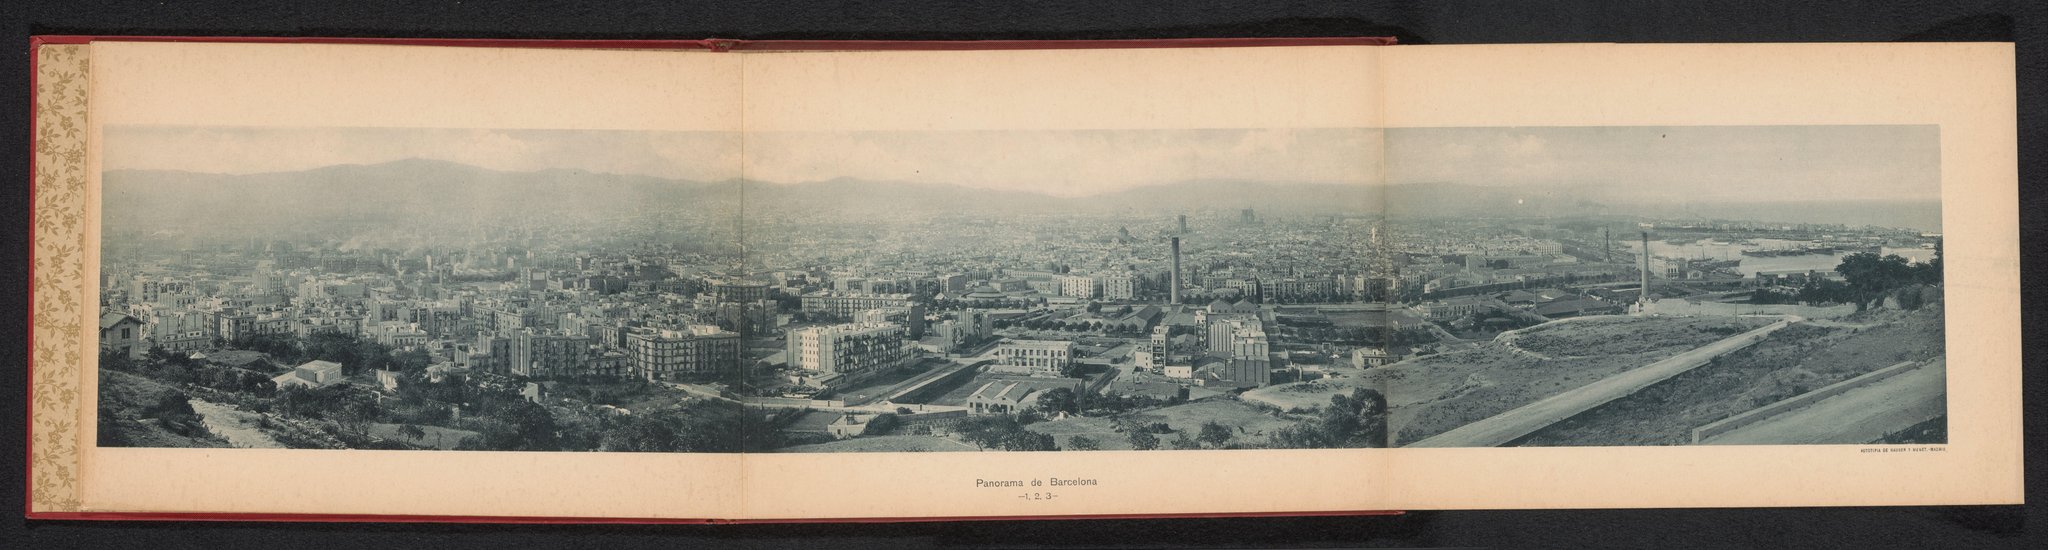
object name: photomechanical print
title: Panorama de Barcelona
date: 1880-1890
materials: paper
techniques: photograph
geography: barcelona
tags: city-view in general; 'veduta'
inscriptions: number: ‘-1,2,3-’